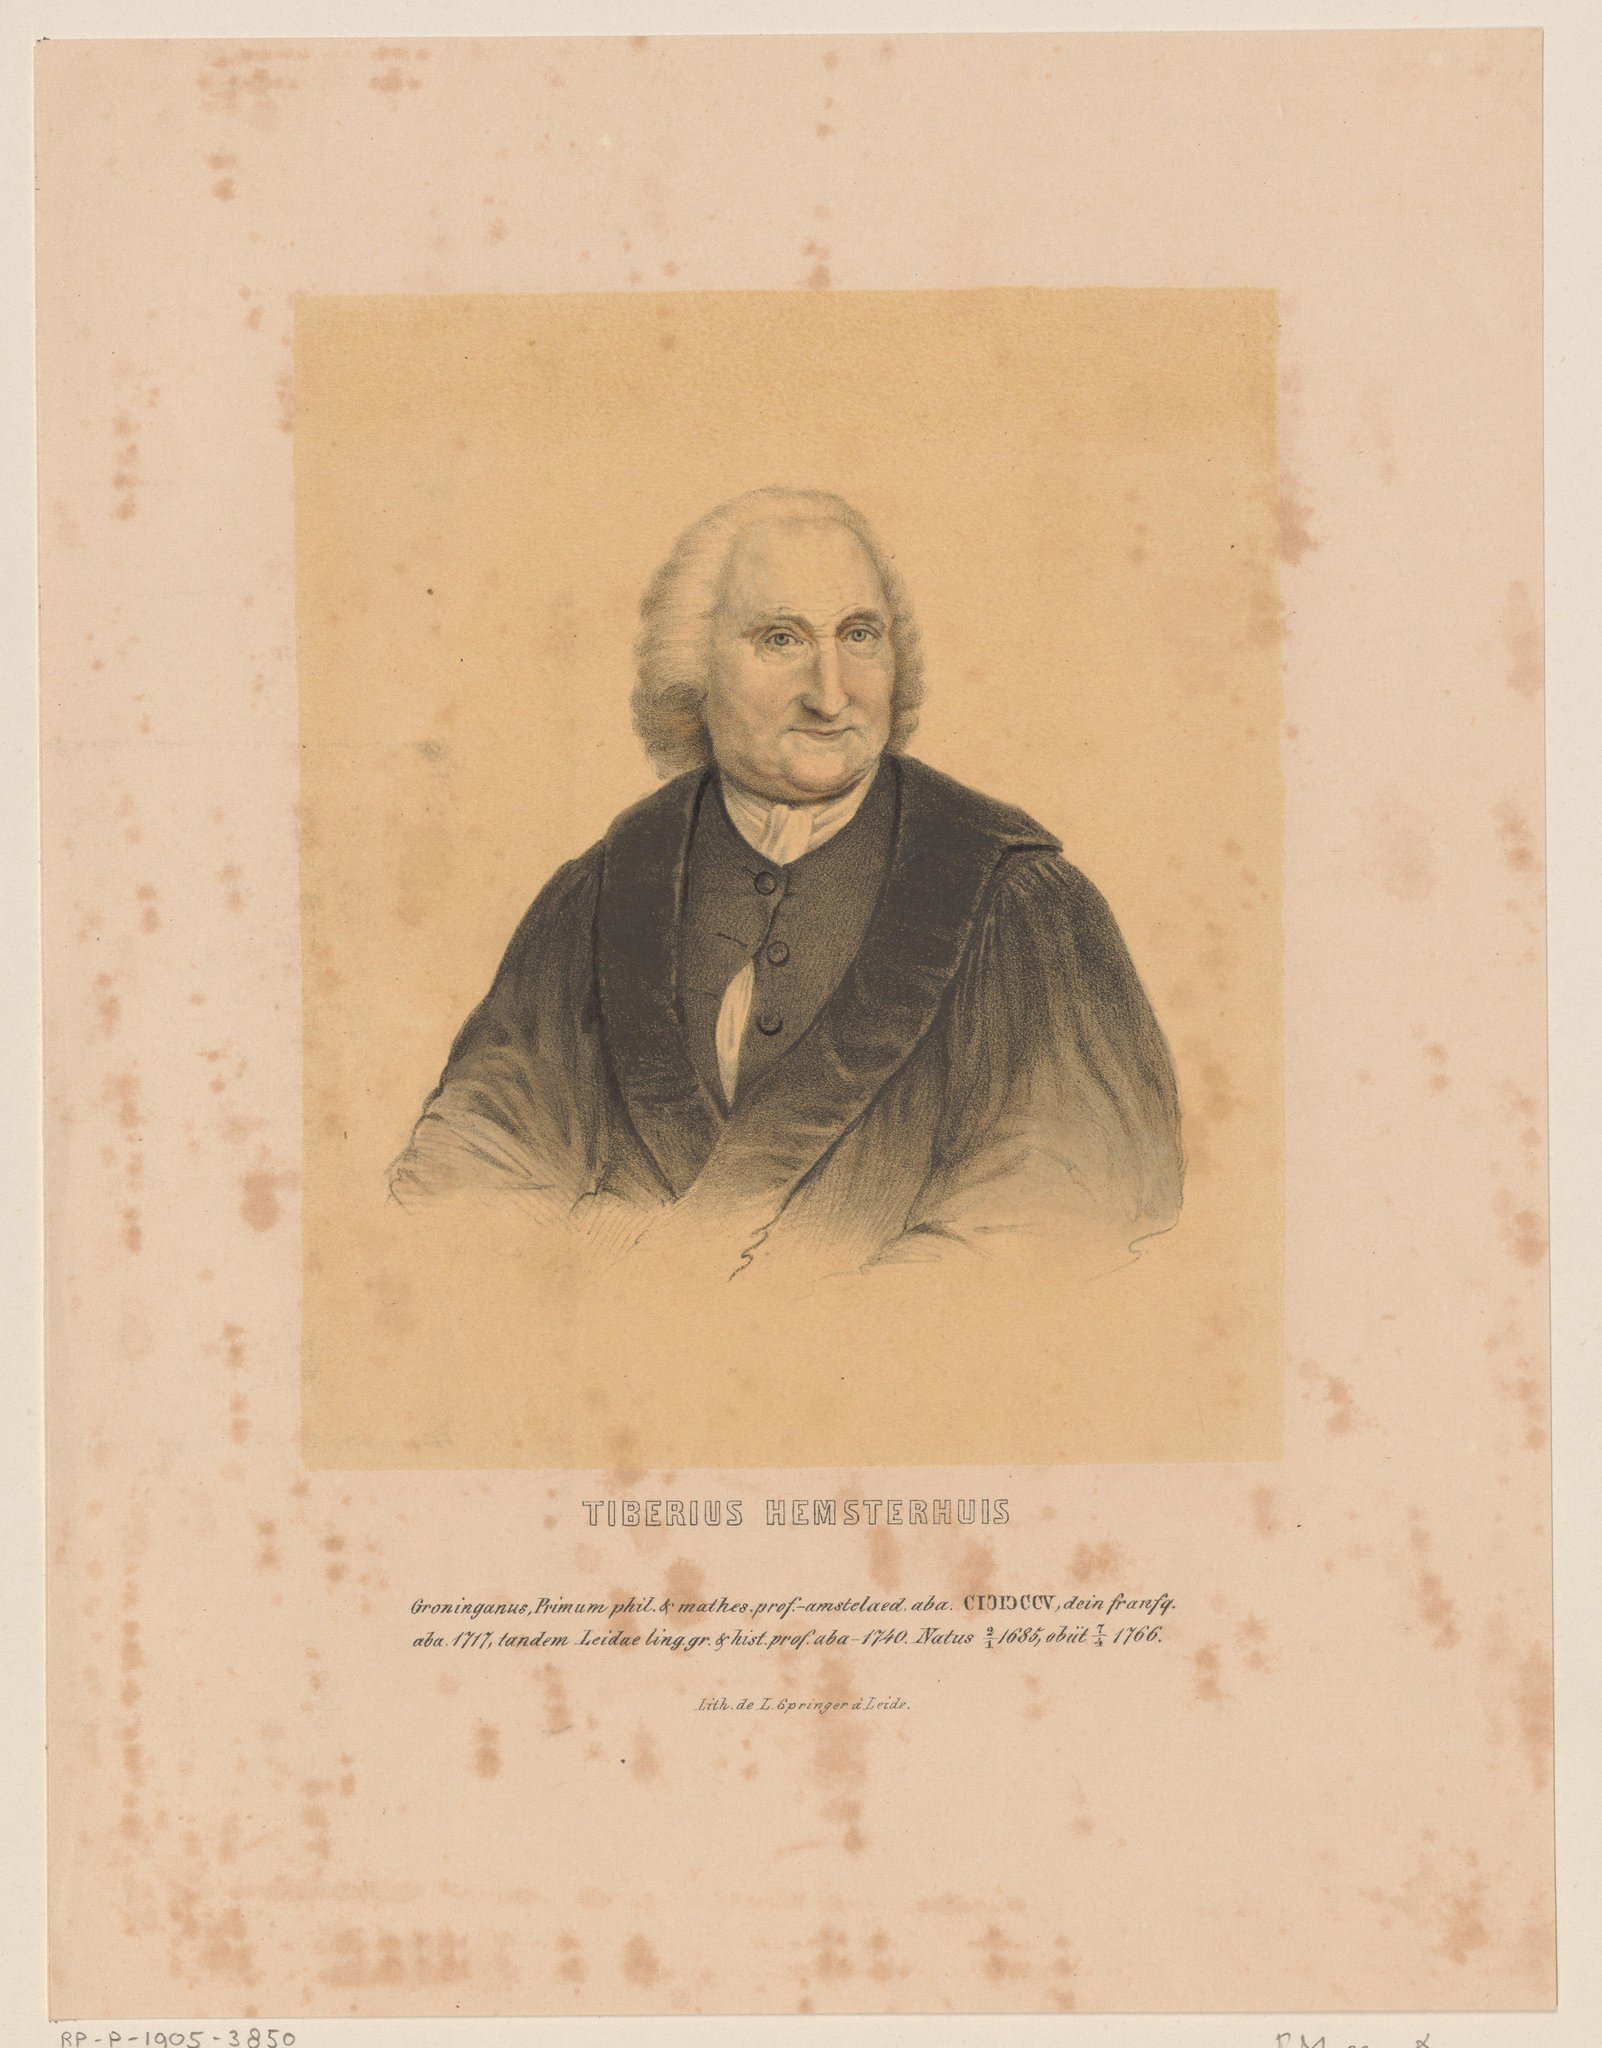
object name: print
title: Portret van Tiberius Hemsterhuis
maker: leendert springer (i)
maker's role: draughtsman, painter, print maker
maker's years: 1789-1871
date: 1850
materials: paper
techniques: lithograph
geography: leiden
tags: scholar, philosopher, historical persons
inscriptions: collector's mark: Lugt 2228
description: Prent uit: Springer, Leendert. Galerij van hoogleeraren aan de Hoogeschool te Leijden, naar de oorspronkelijke afbeeldsels op de Senaat-zaal aldaar berustende. Leiden: Leendert Springer, [1850].